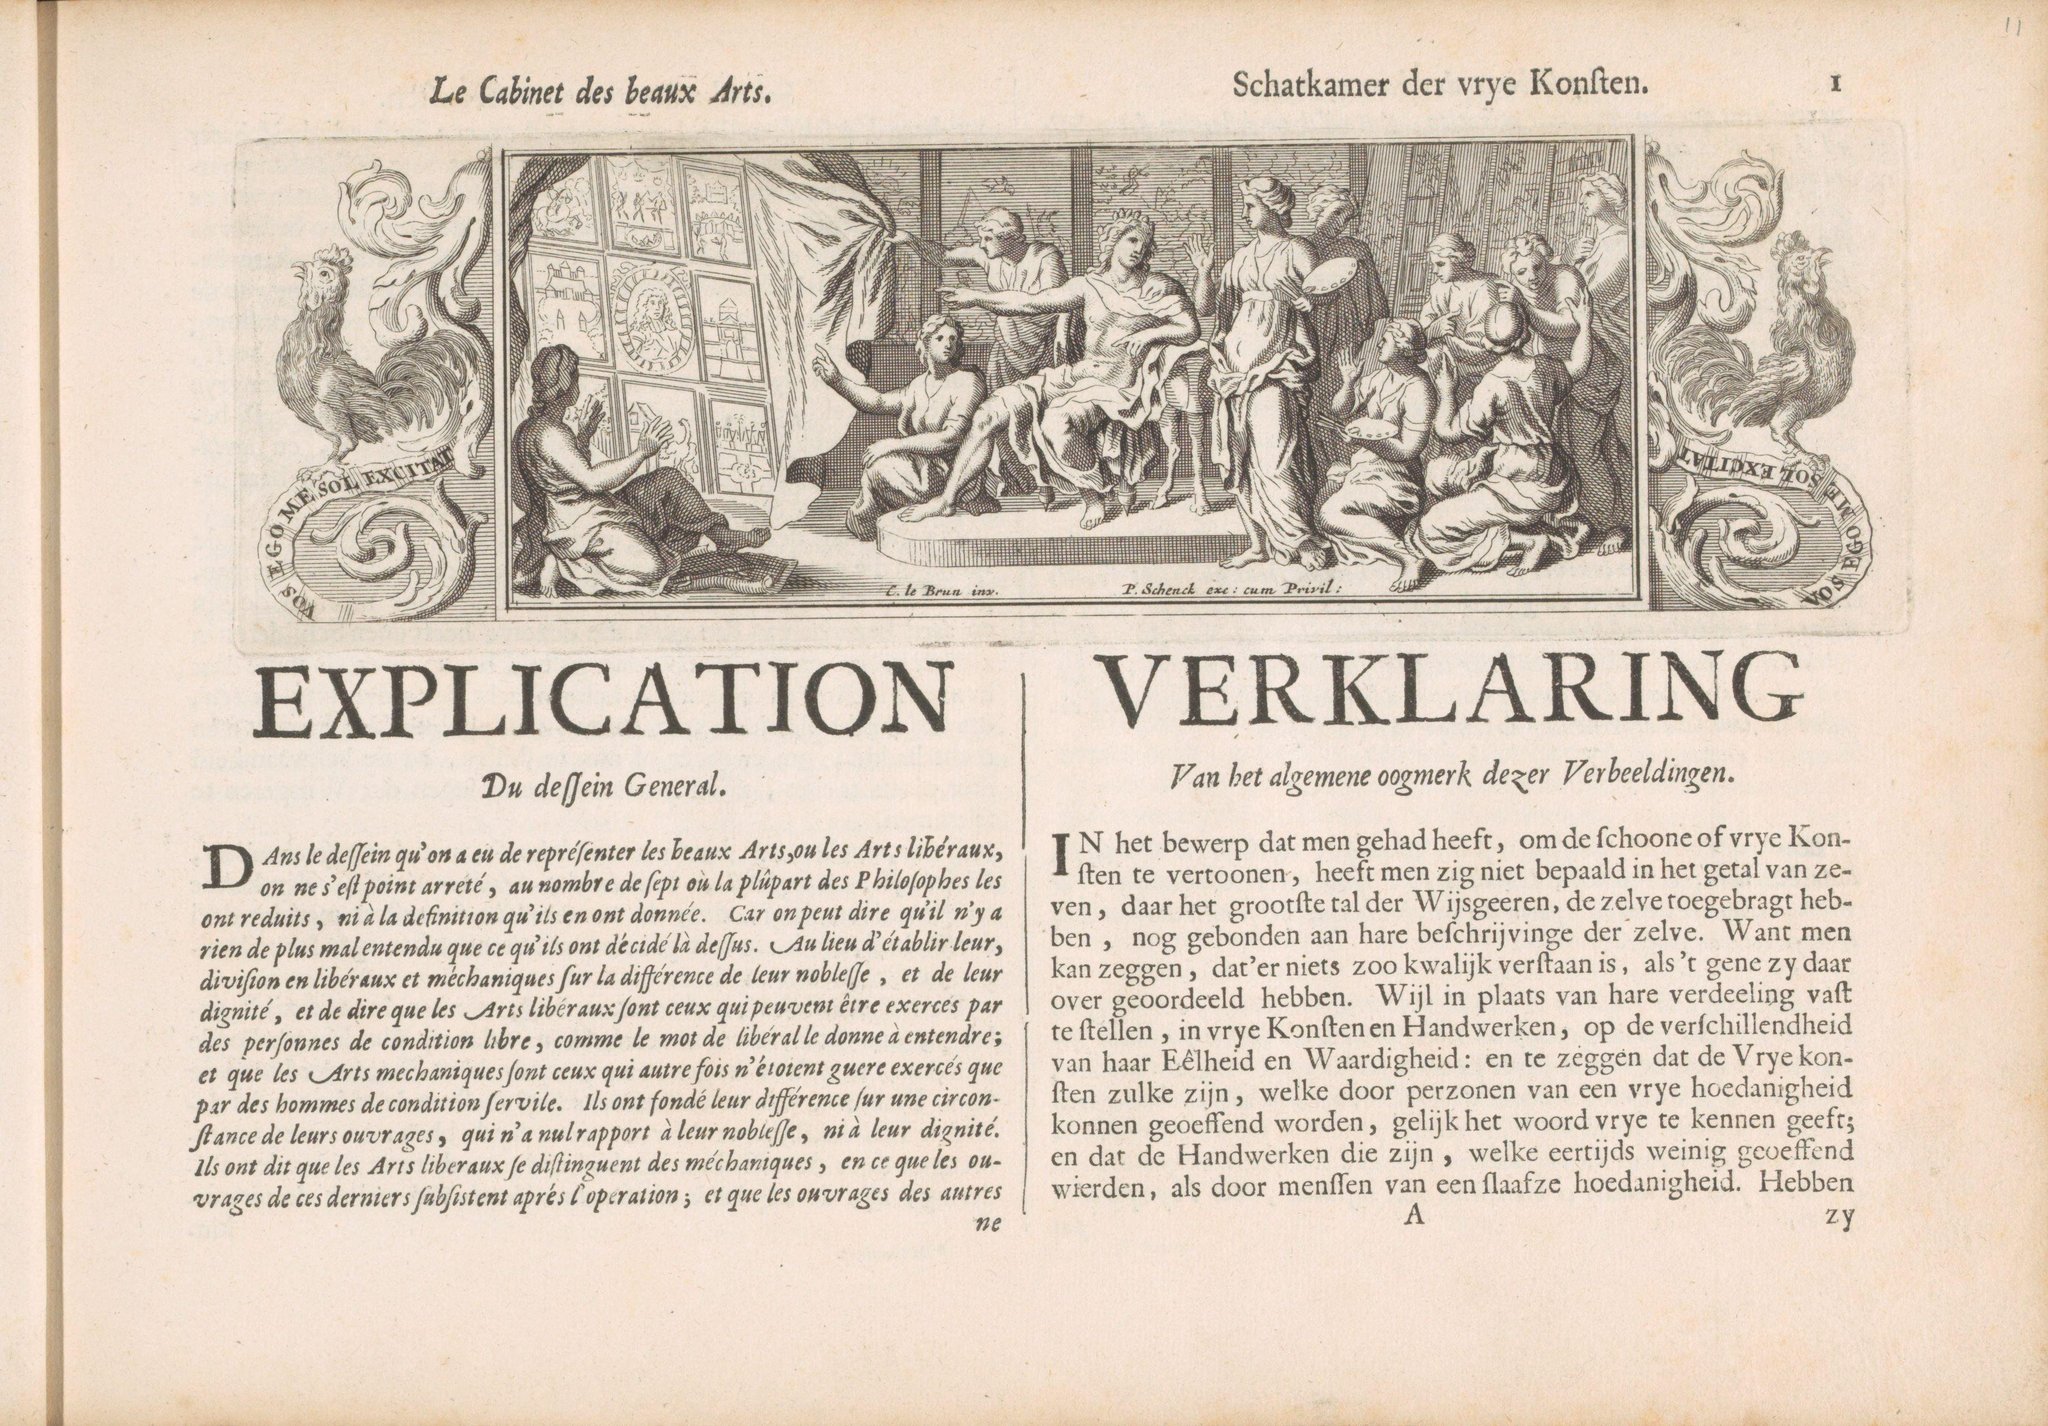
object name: album leaf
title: Explication du dessein General / Verklaring Van het algemene oogmerk dezer Verbeeldingen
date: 1693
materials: paper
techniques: engraving, etching, letterpress printing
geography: amsterdam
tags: apollo and the muses, apollo musagetes, 'pictura', symbolic representations, allegories and emblems ~ painting; 'pittura' (ripa)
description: Apollo, omringd door de muzen, wijst op een veelluik met verschillende voorstellingen. Bij hem staat de personificatie van de Schilderkunst met palet en kwasten in de hand. Links en rechts naast deze voorstelling een haan met banderol. Onder de prent tekst in het Frans en het Nederlands, pagina 1. Prent maakt deel uit van een album.